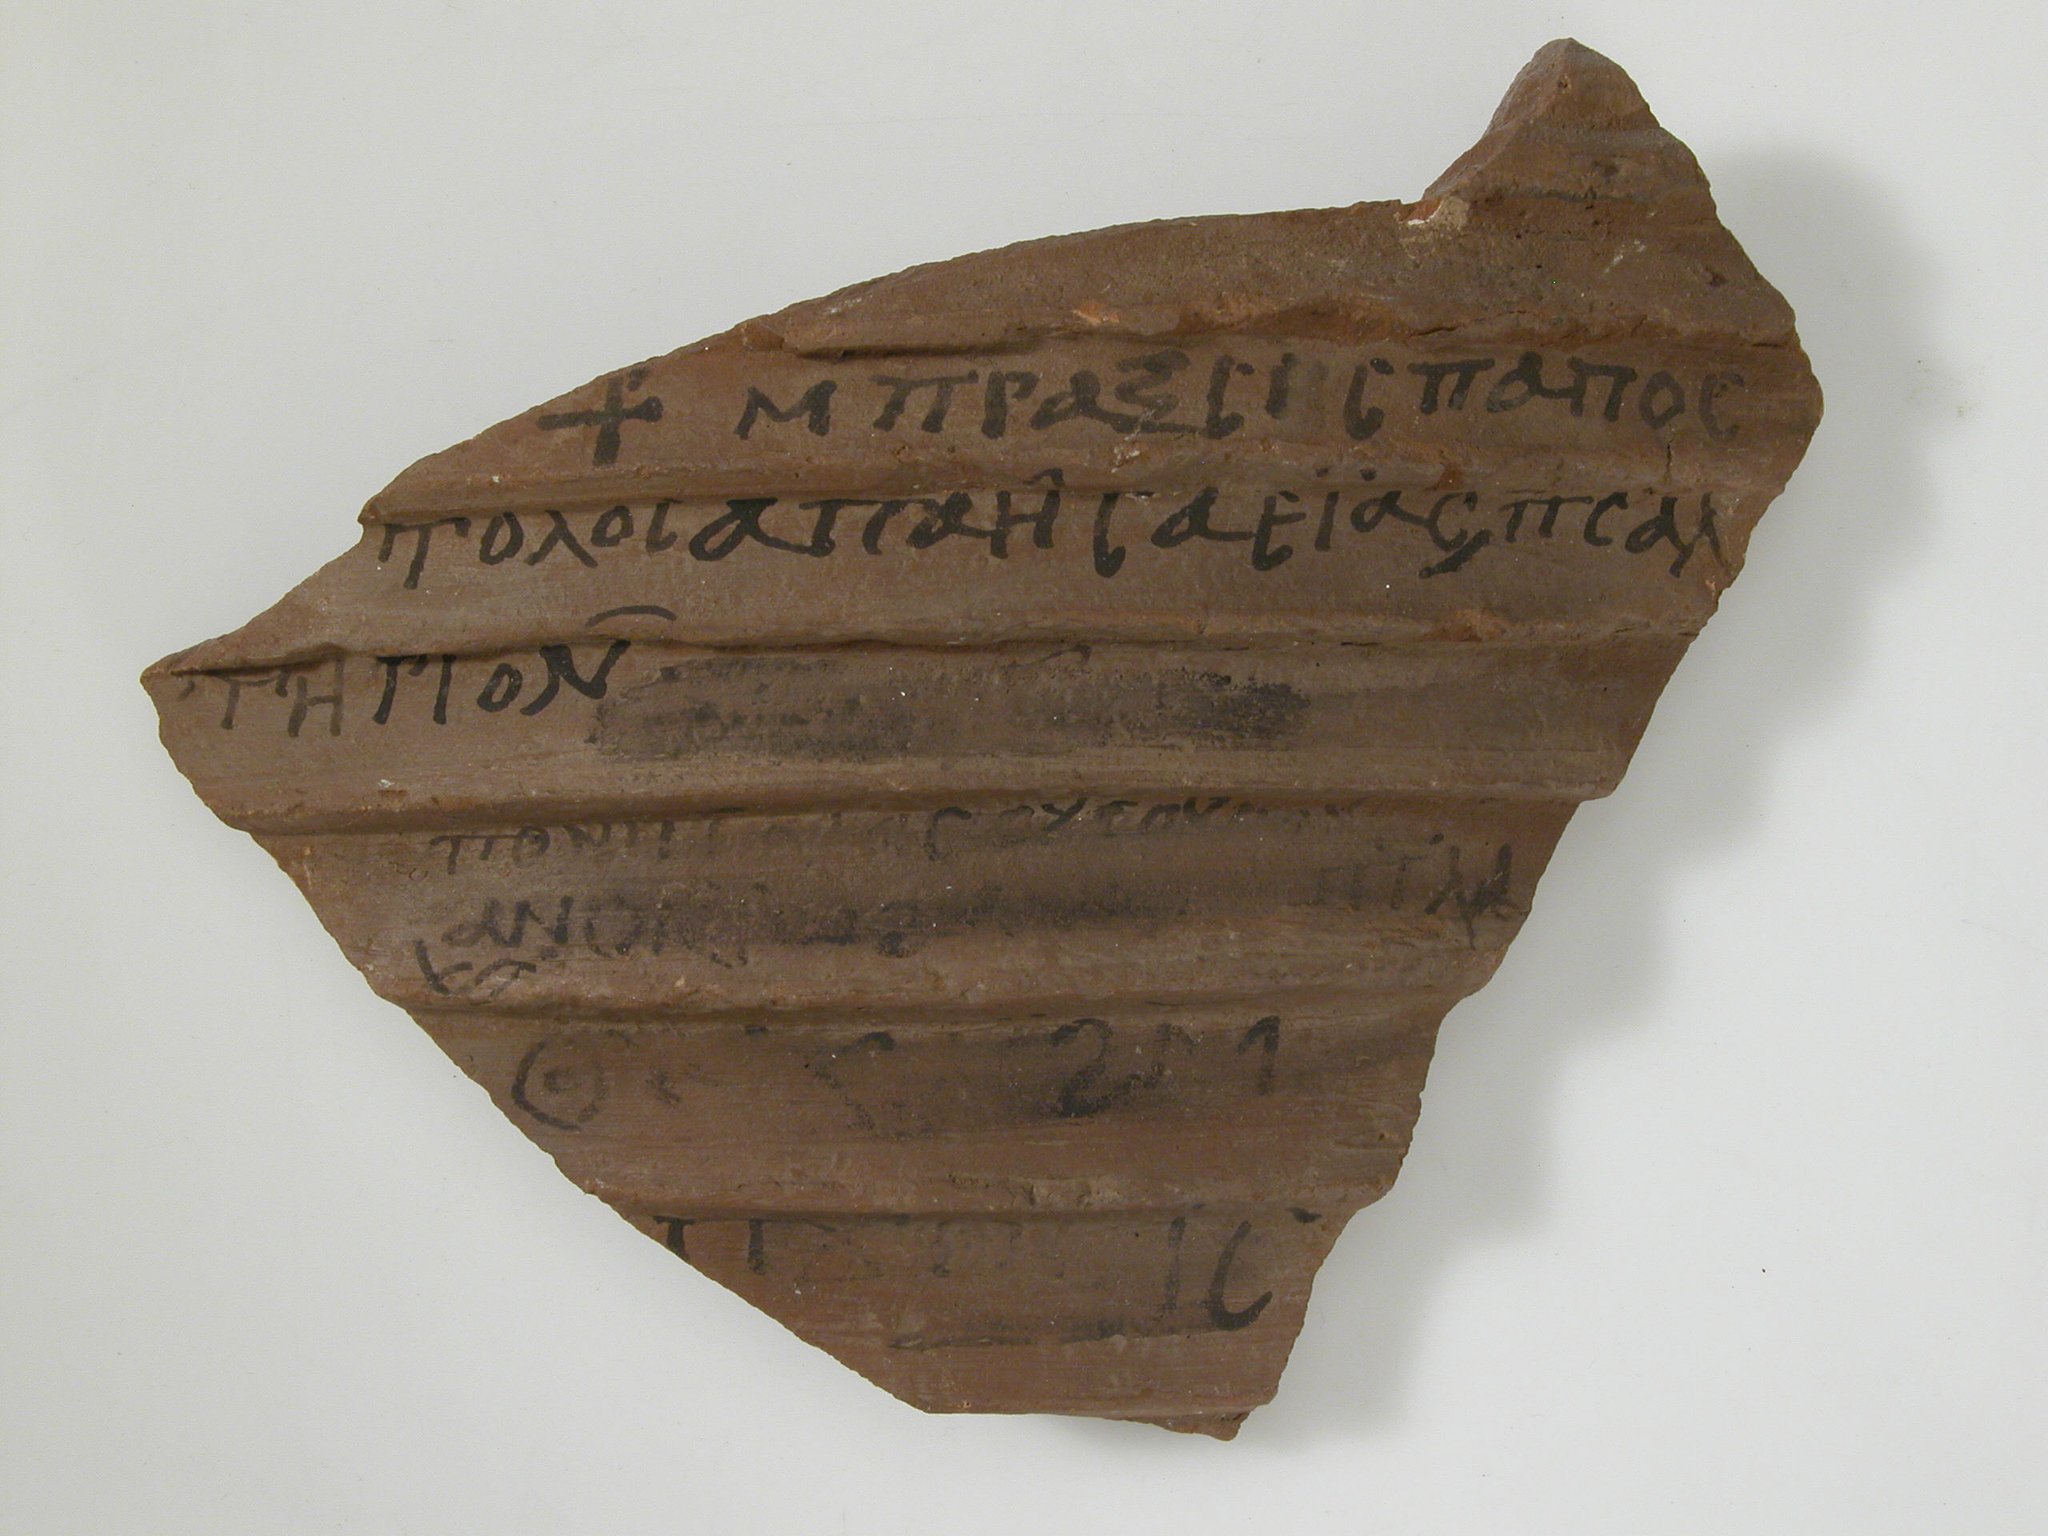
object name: ostrakon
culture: coptic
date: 601-700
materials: ink, pottery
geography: egypt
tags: documents